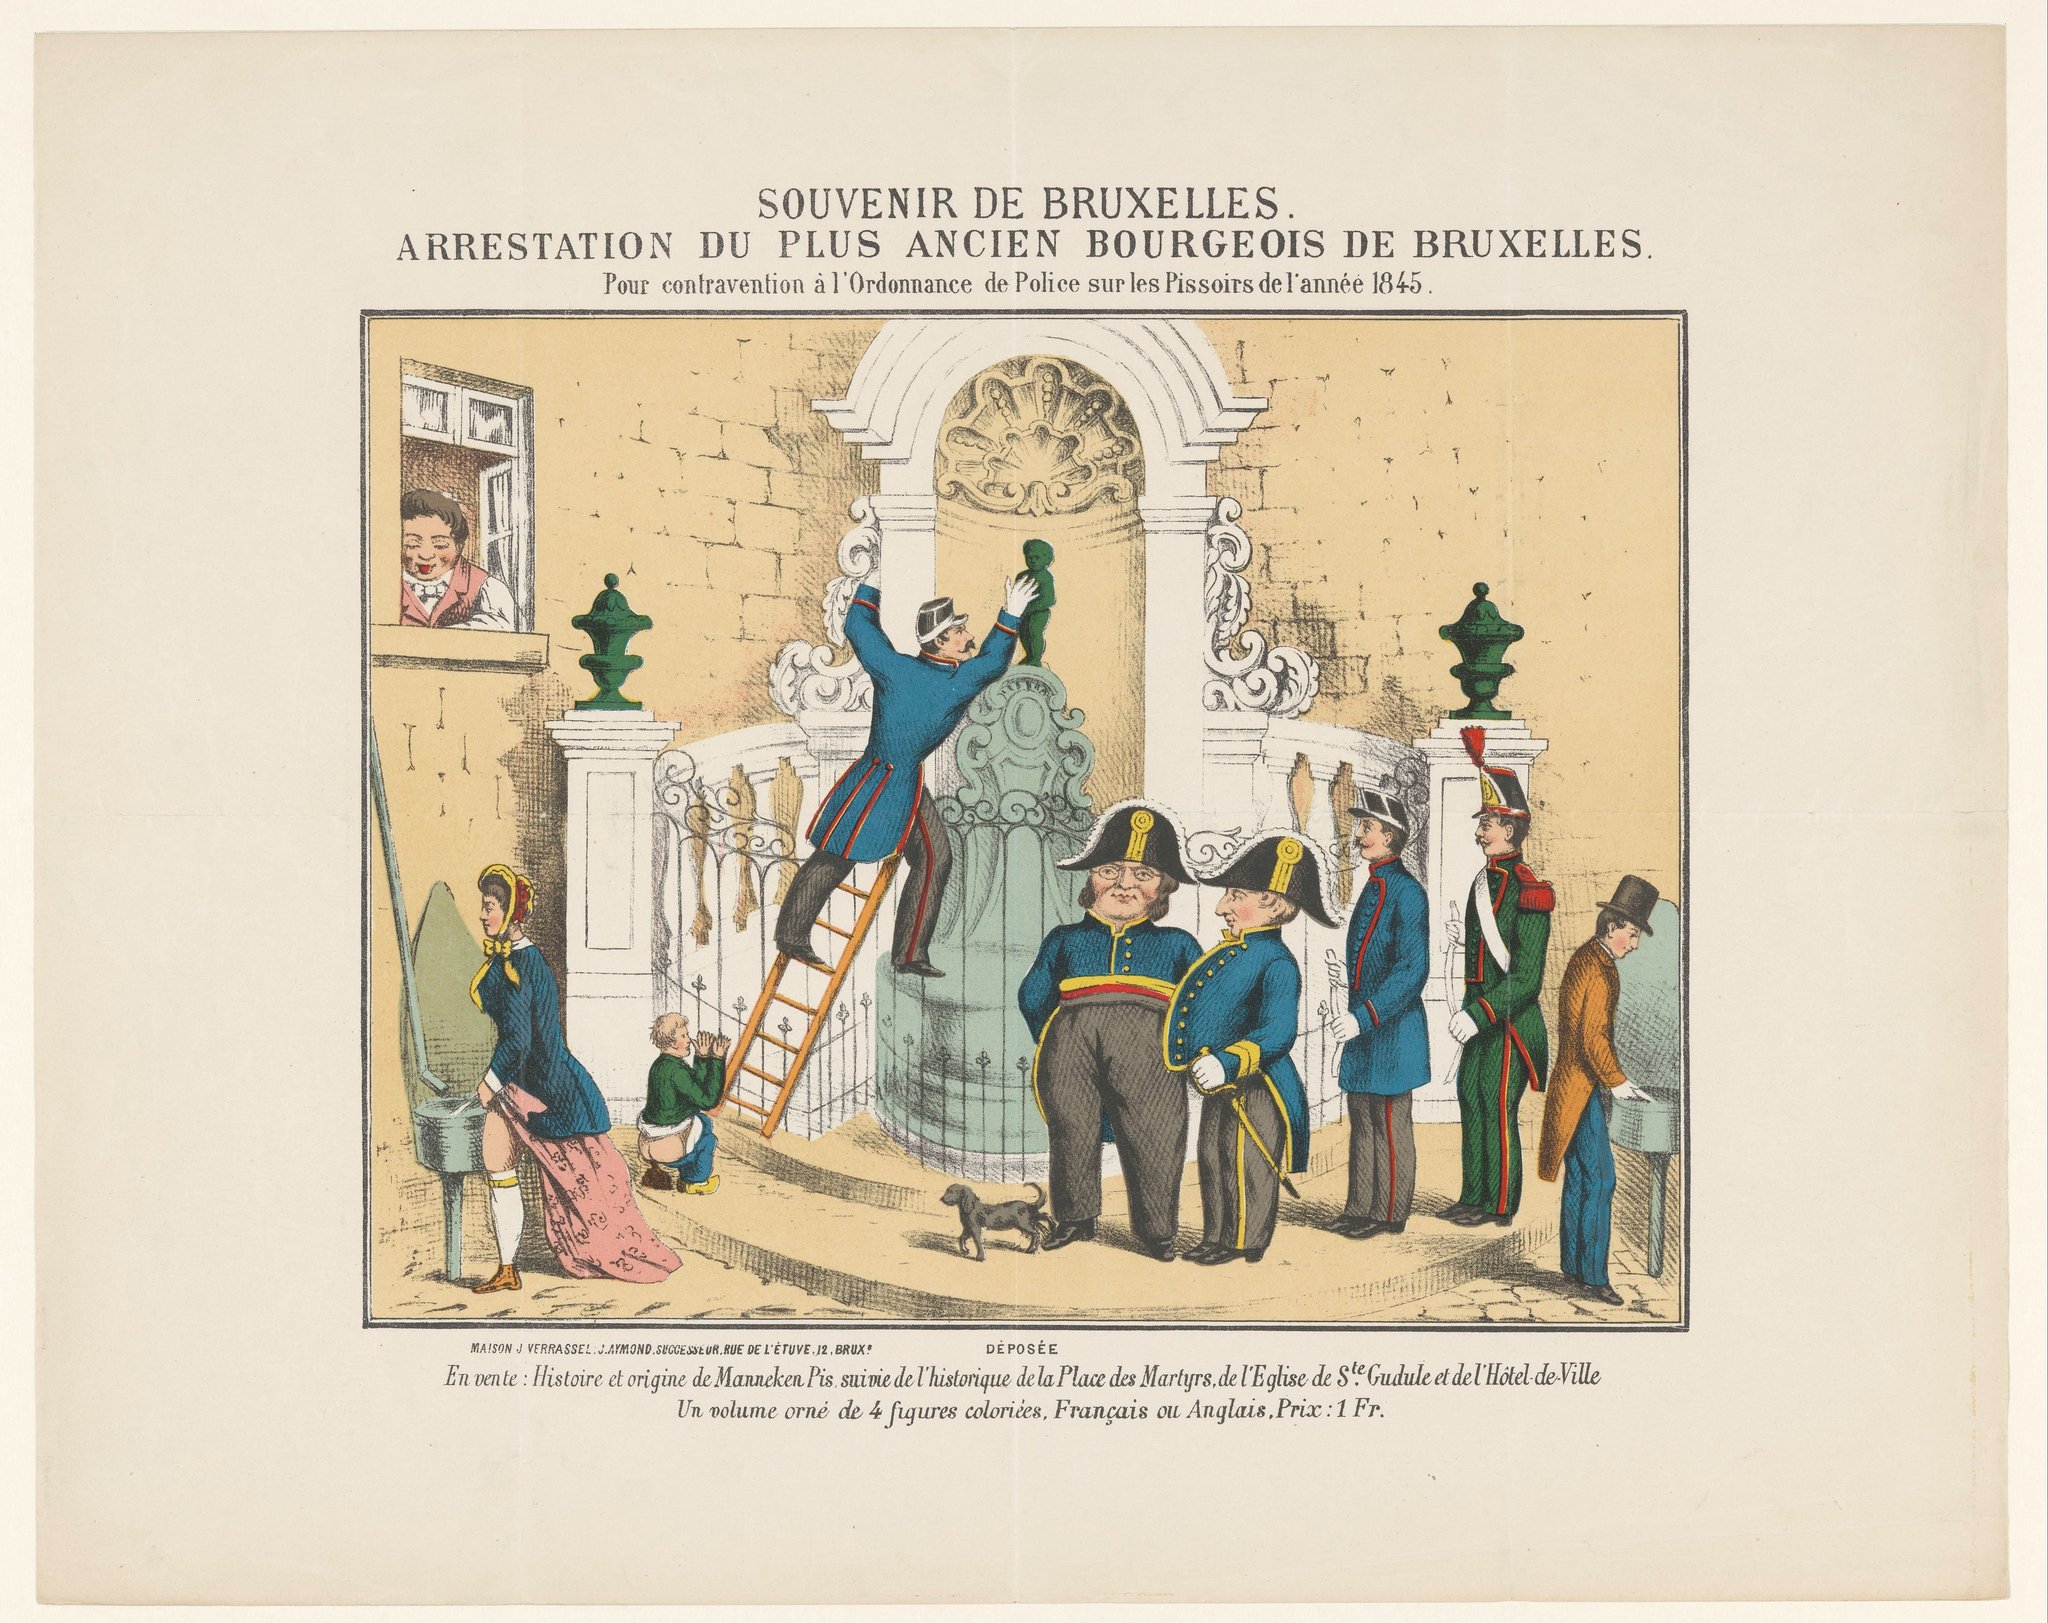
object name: print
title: Arrestatie van Manneken Pis, 1845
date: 1845-1850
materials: paper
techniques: lithograph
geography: brussels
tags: urination - aa - female human figure, arrest (of criminal), urination, defecation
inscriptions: collector's mark: Lugt 2760, collector's mark: Lugt 2228, : ‘Déposée’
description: Spotprent met de arrestatie van Manneken Pis wegens het overtreden van de verordening over het gebruik van openbare toiletten van 1845. Ondertussen doen een vrouw, kind en man in het openbaar hun behoefte.